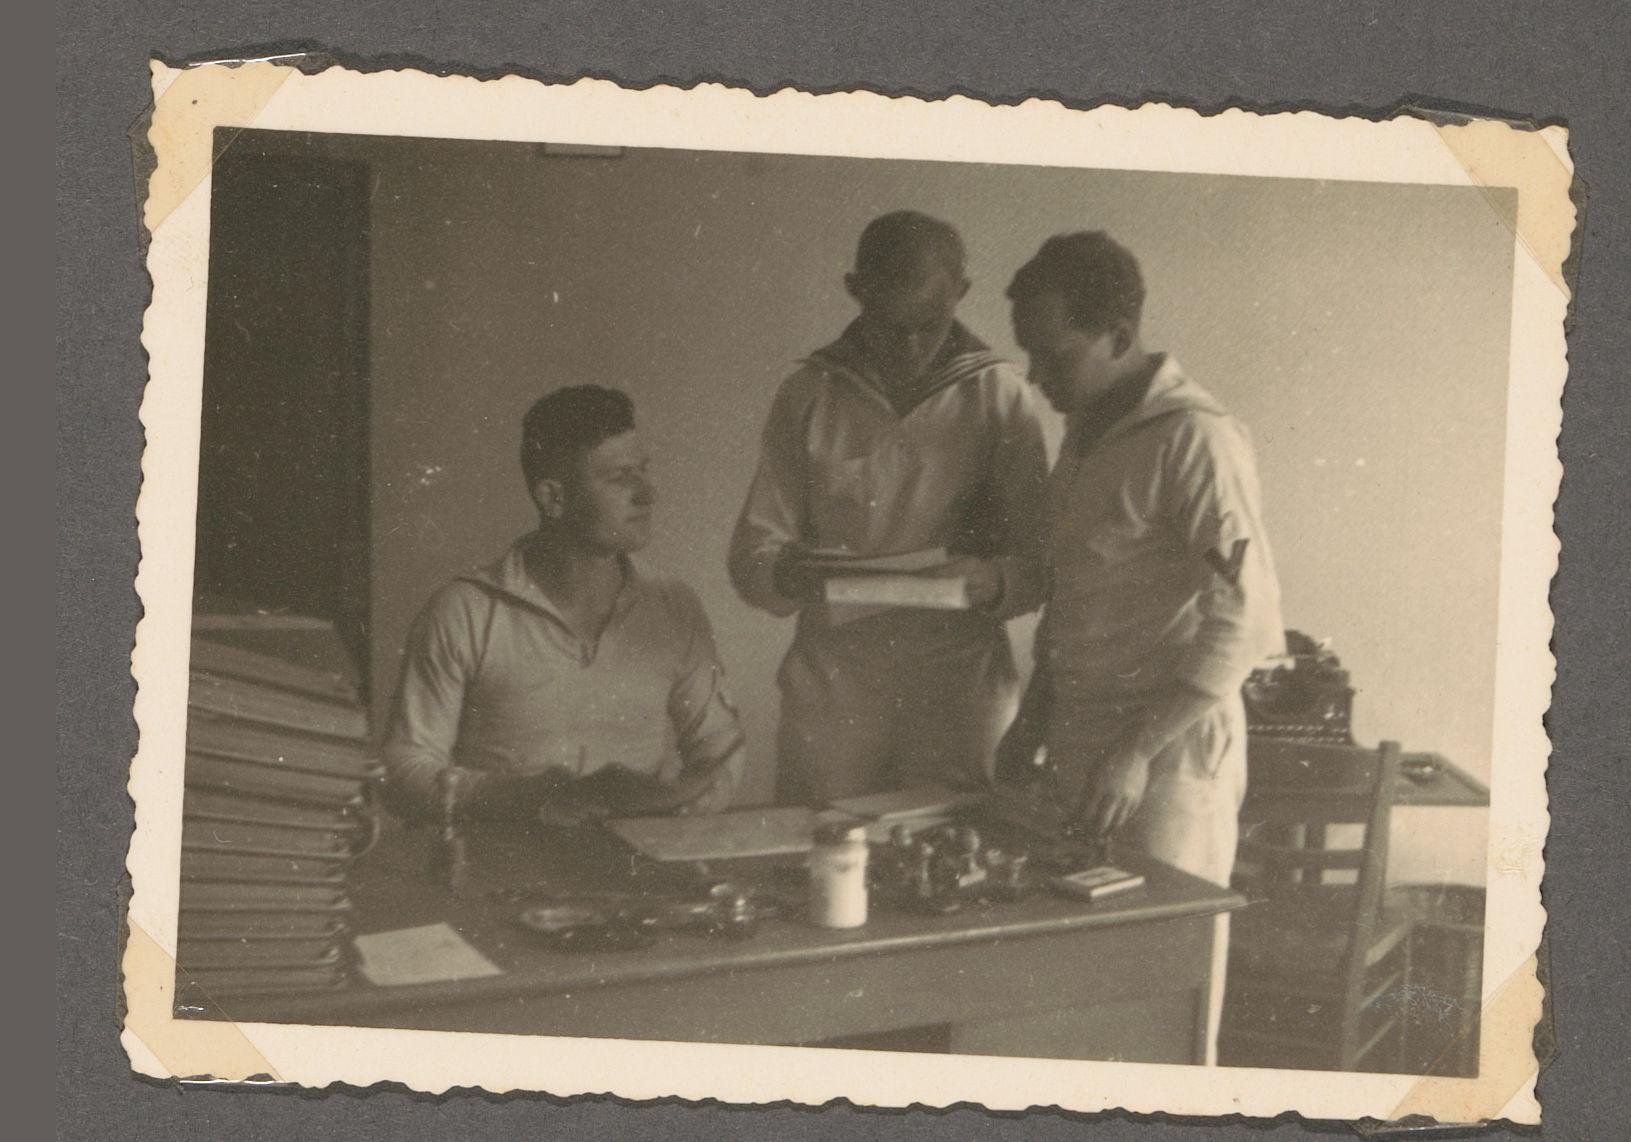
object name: photograph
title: Registratur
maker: Anonymous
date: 1941-1945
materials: paper, photographic support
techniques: gelatin silver print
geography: netherlands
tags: adult man, historical persons, occupation ~ war, netherlands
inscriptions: annotation: ‘Waibel, Blume, Hille’